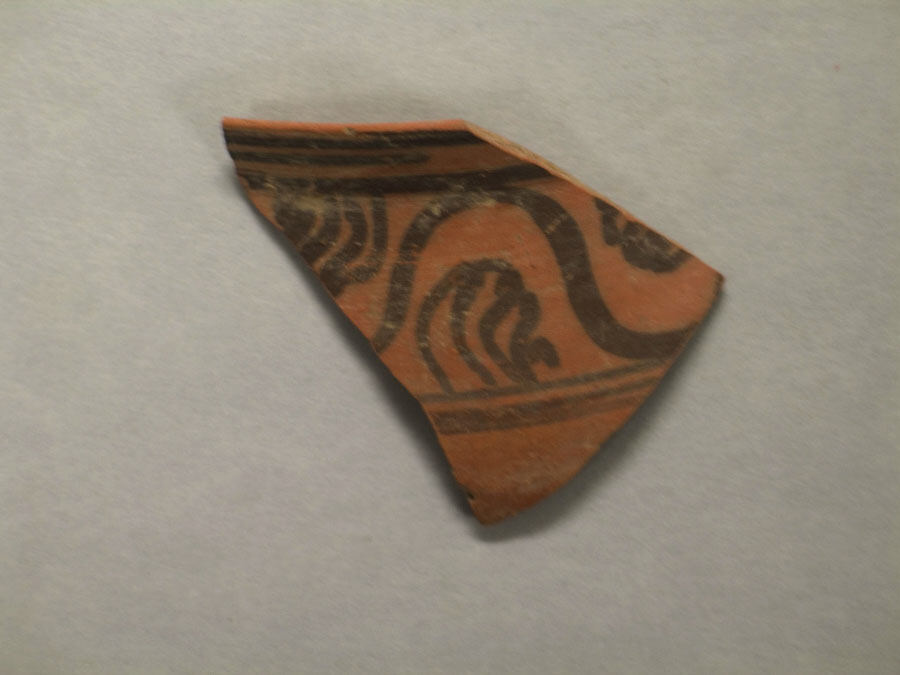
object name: shard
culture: pakistani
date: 301-500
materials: terracotta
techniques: painting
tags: gandhara